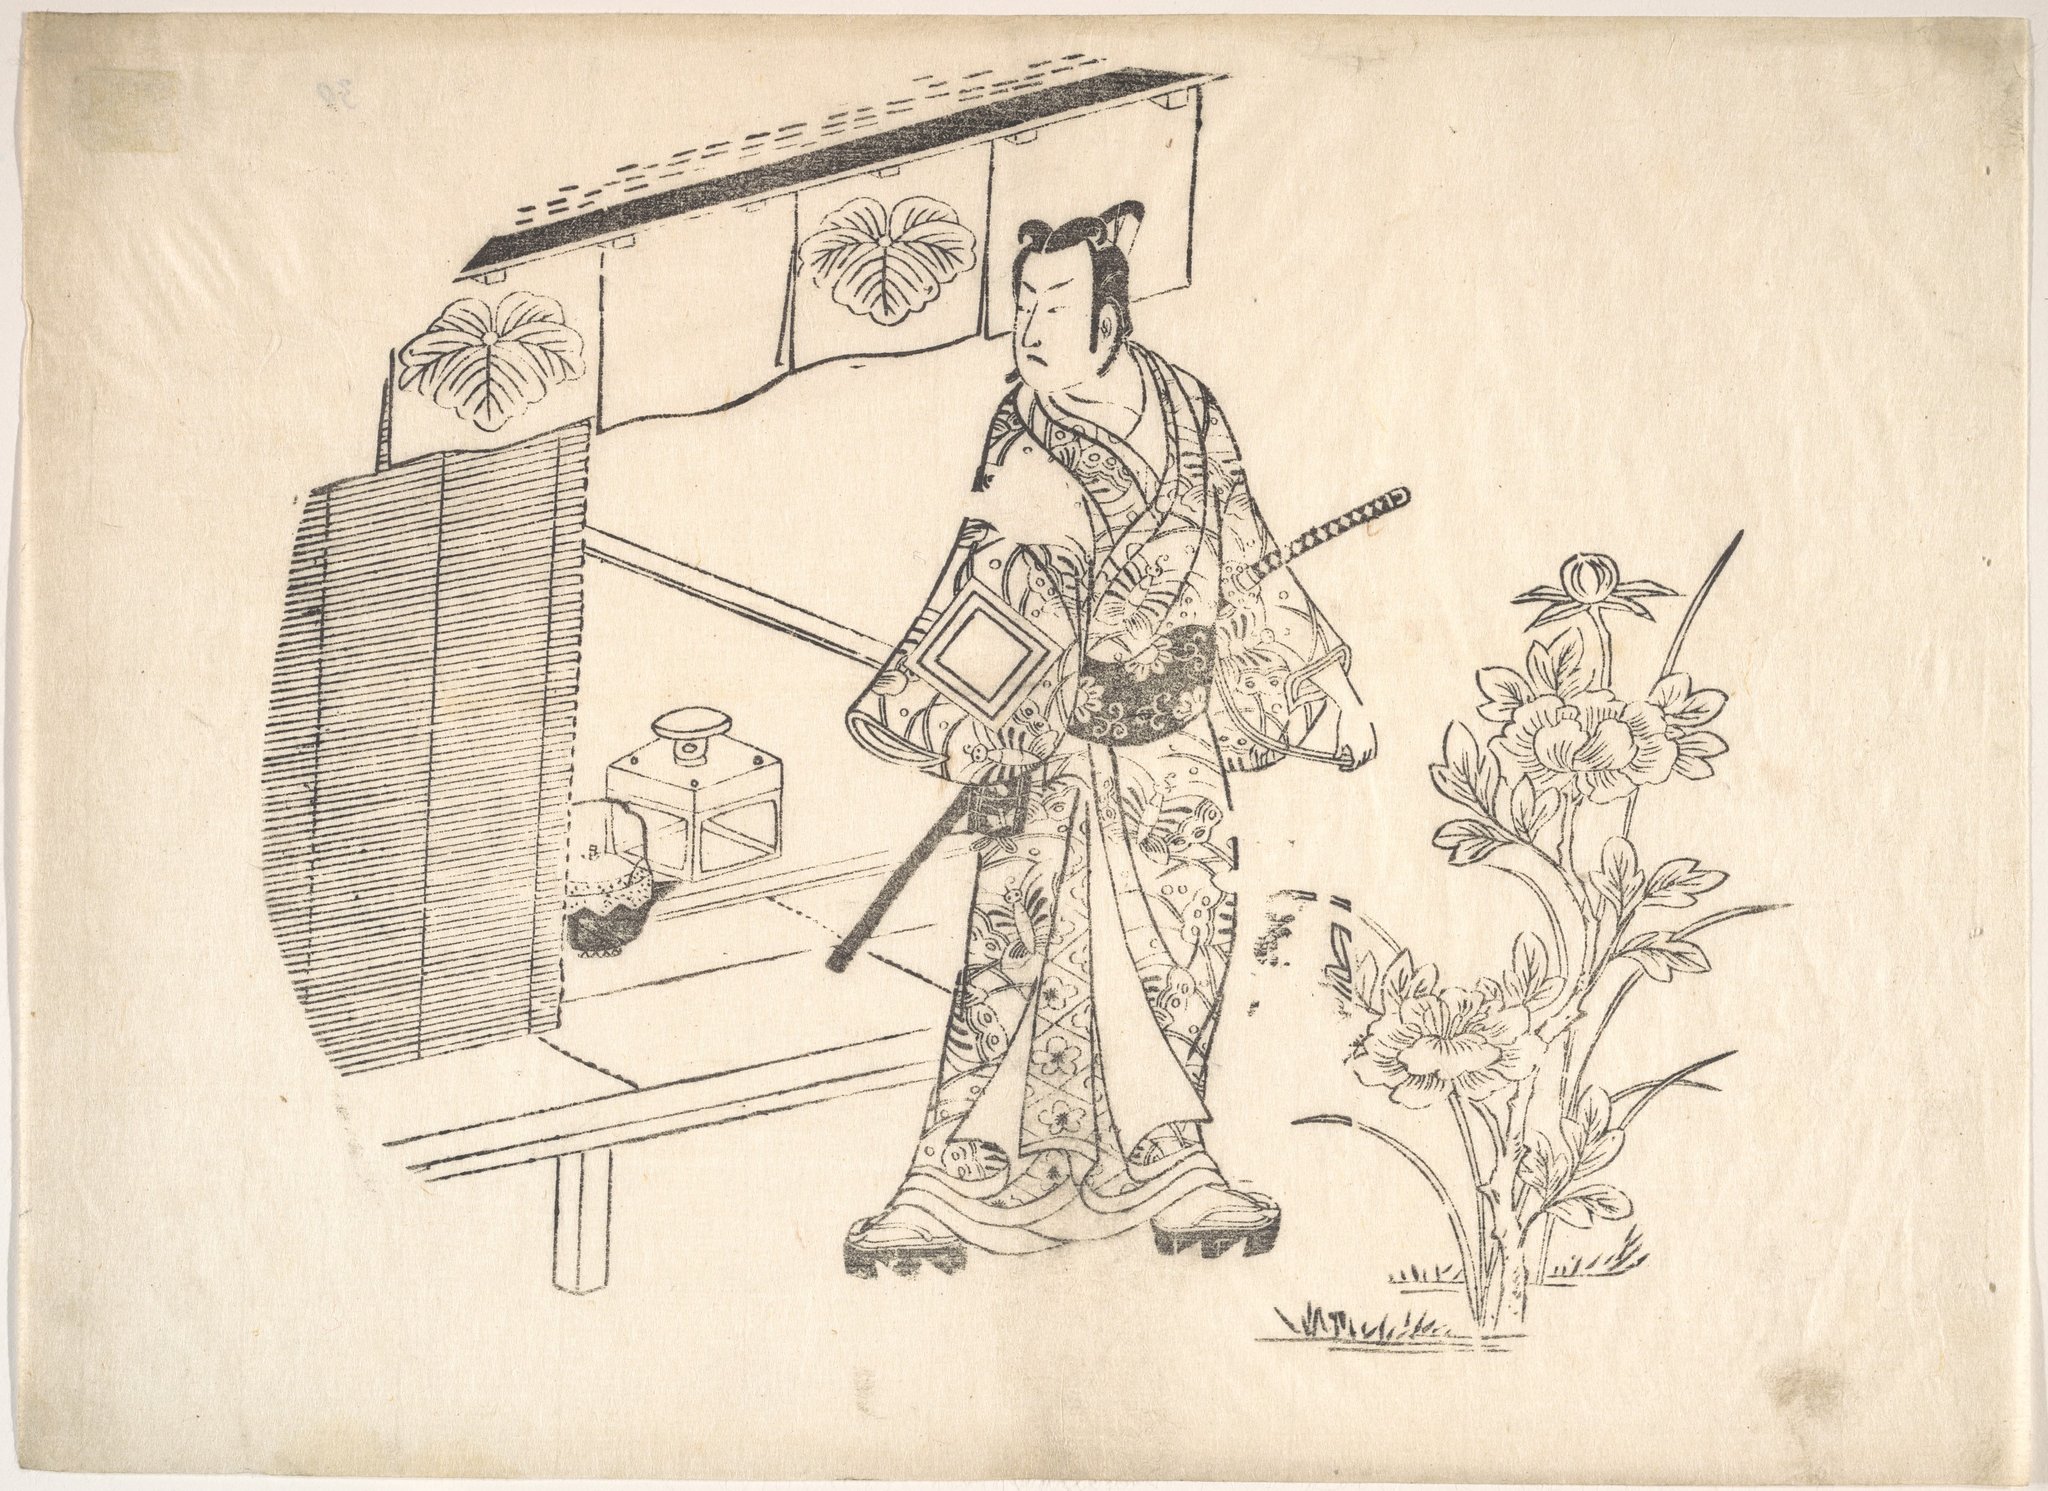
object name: print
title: One of Six Impressions from Worn Old Blocks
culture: japanese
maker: unidentified artist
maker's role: artist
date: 1700-1799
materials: ink, paper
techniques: woodblock print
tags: men,flowers,plants